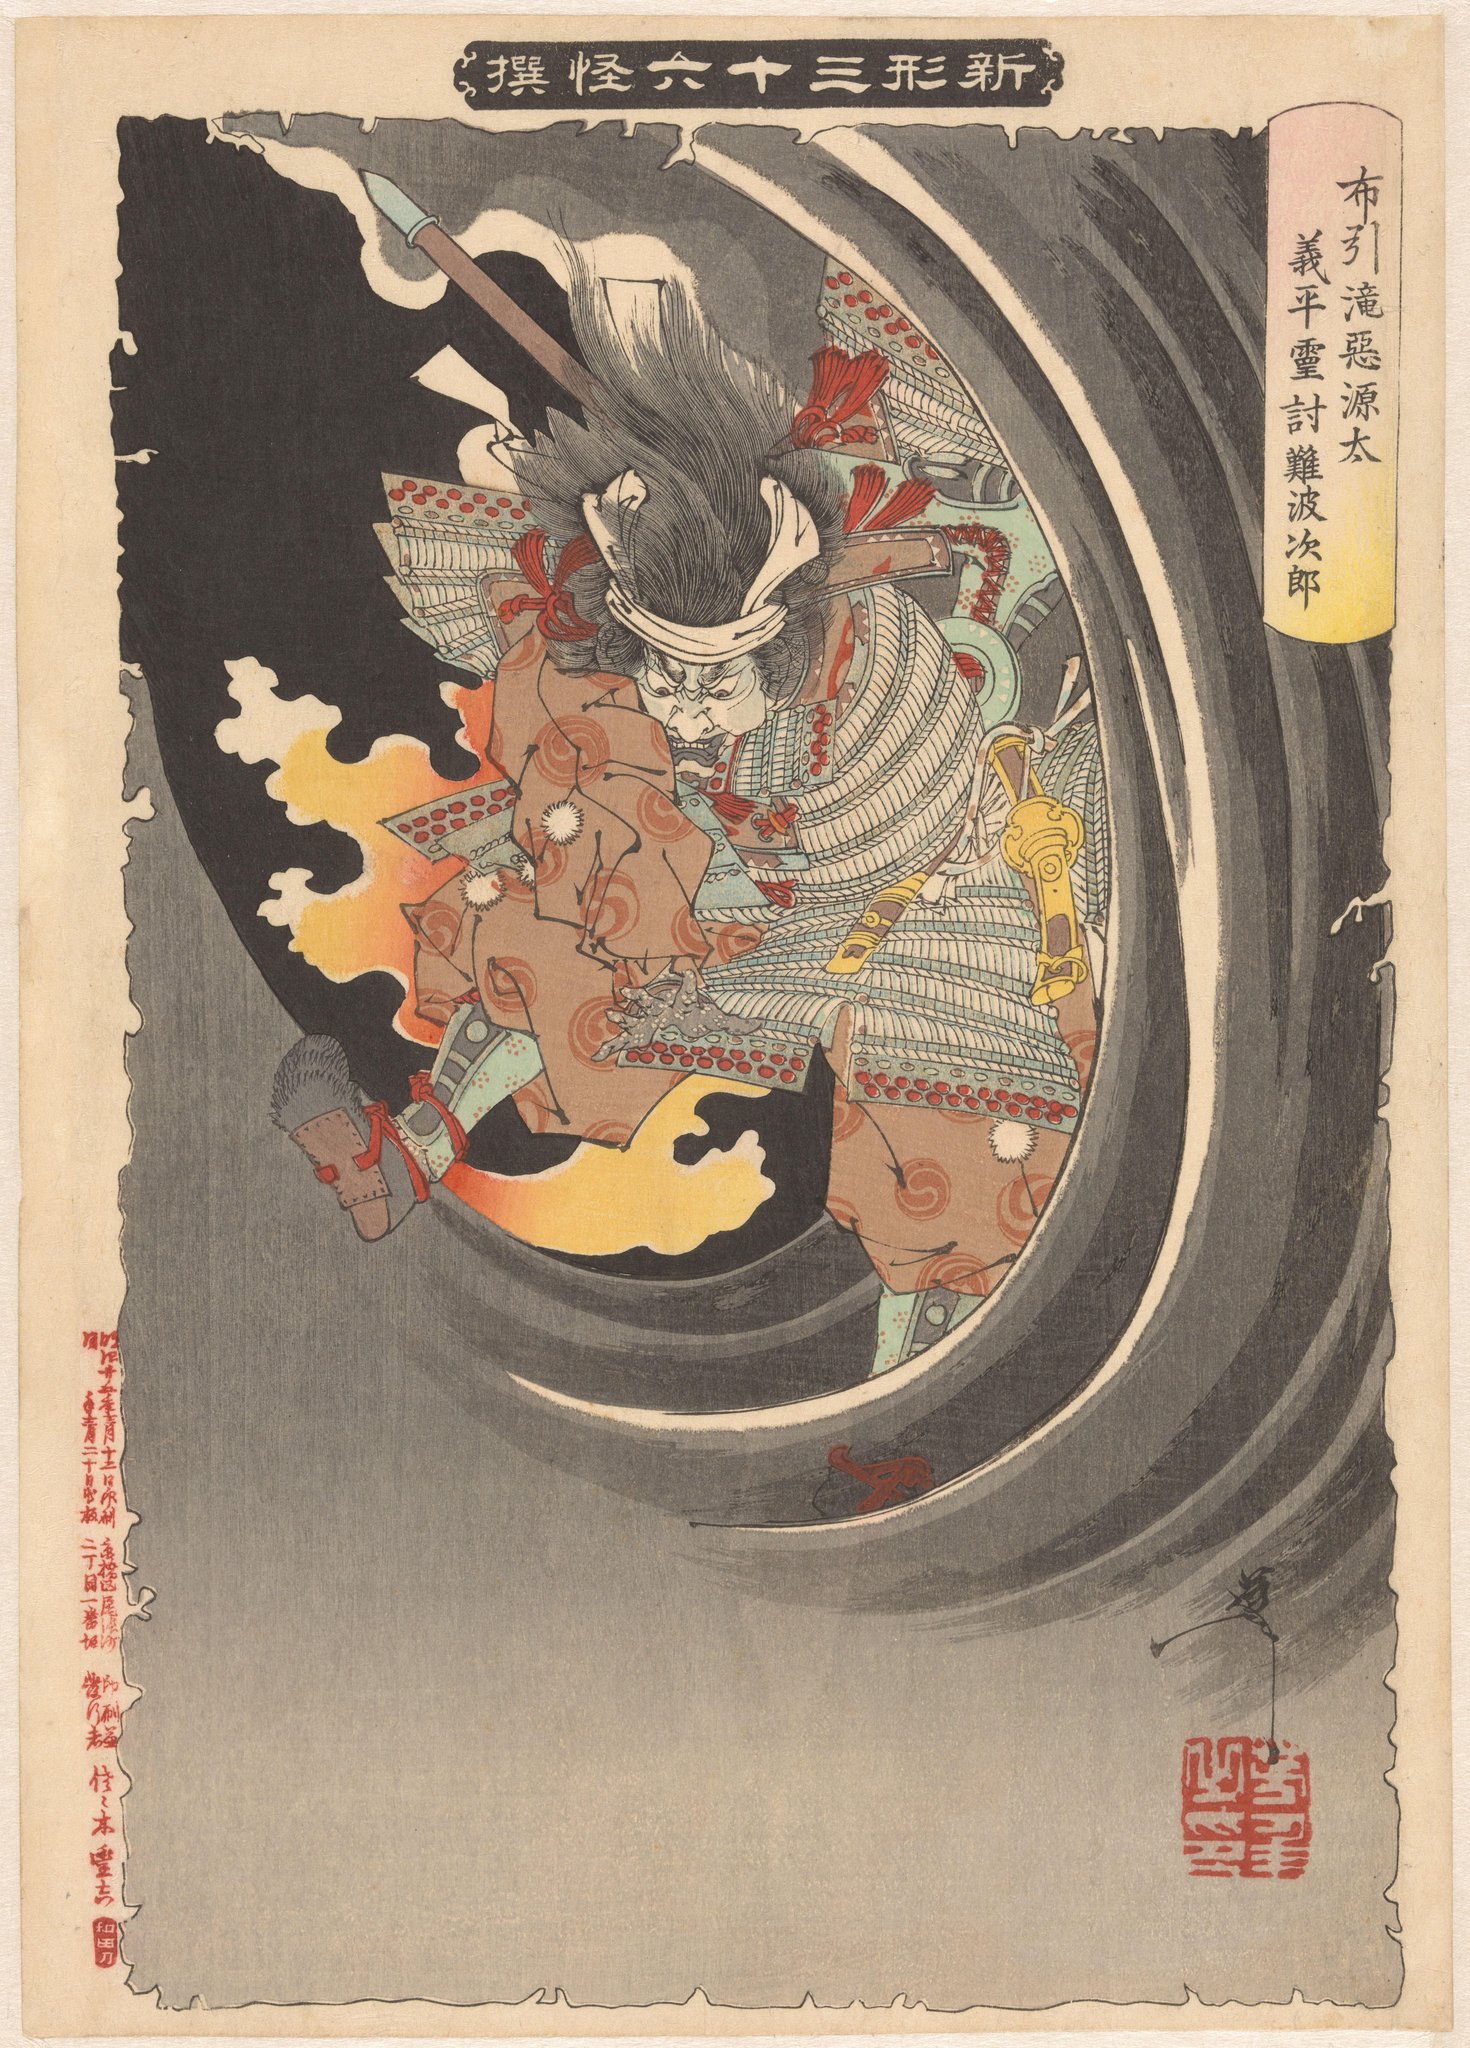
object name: print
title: New forms of 36 ghosts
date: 1812-1889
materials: paper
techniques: woodcut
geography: japan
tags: spirit, ghost, storm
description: Een woest kijkende man afgebeeld middenin een donkere stormachtige lucht met bliksemschichten. Dit is de geest van Genta Yoshihira die op wraak uit is nadat zijn vader verslagen werd. Volgens het verhaal veranderde Genta Yoshihira in een dondergod vlak voordat hij onthoofd werd door Nanba no Jirô en doodde Nanba vervolgens met een bliksemschicht